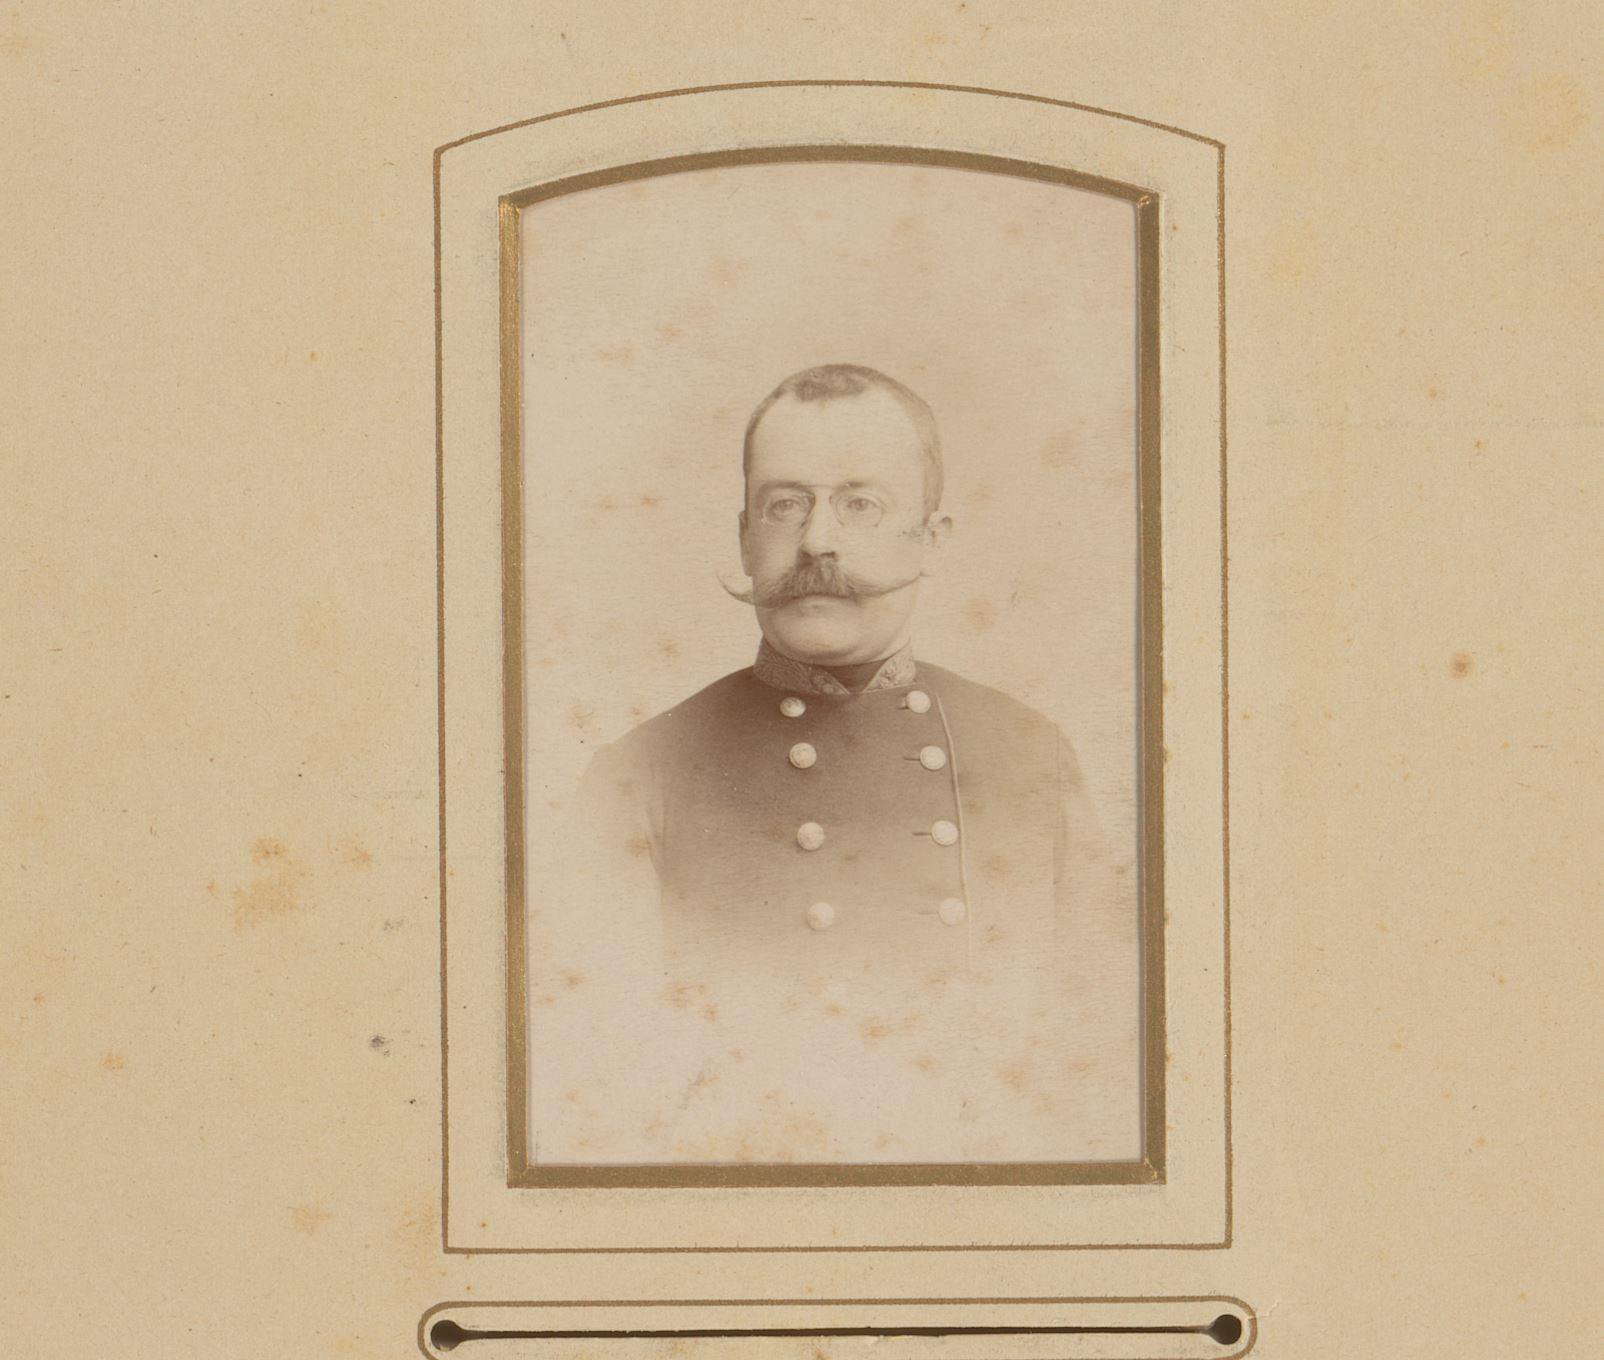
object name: carte de visite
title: Portret van een man in uniform met bril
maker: léonard hubert zeyen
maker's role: fotograaf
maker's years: 1840-1907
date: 1880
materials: cardboard, photographic support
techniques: albumen print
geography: liège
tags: eyeglasses, spectacles, historical persons, (military) uniforms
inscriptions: inscription: ‘L. H. Zeyen/ Liège./ Boulevard de la Sauvenière 137.’